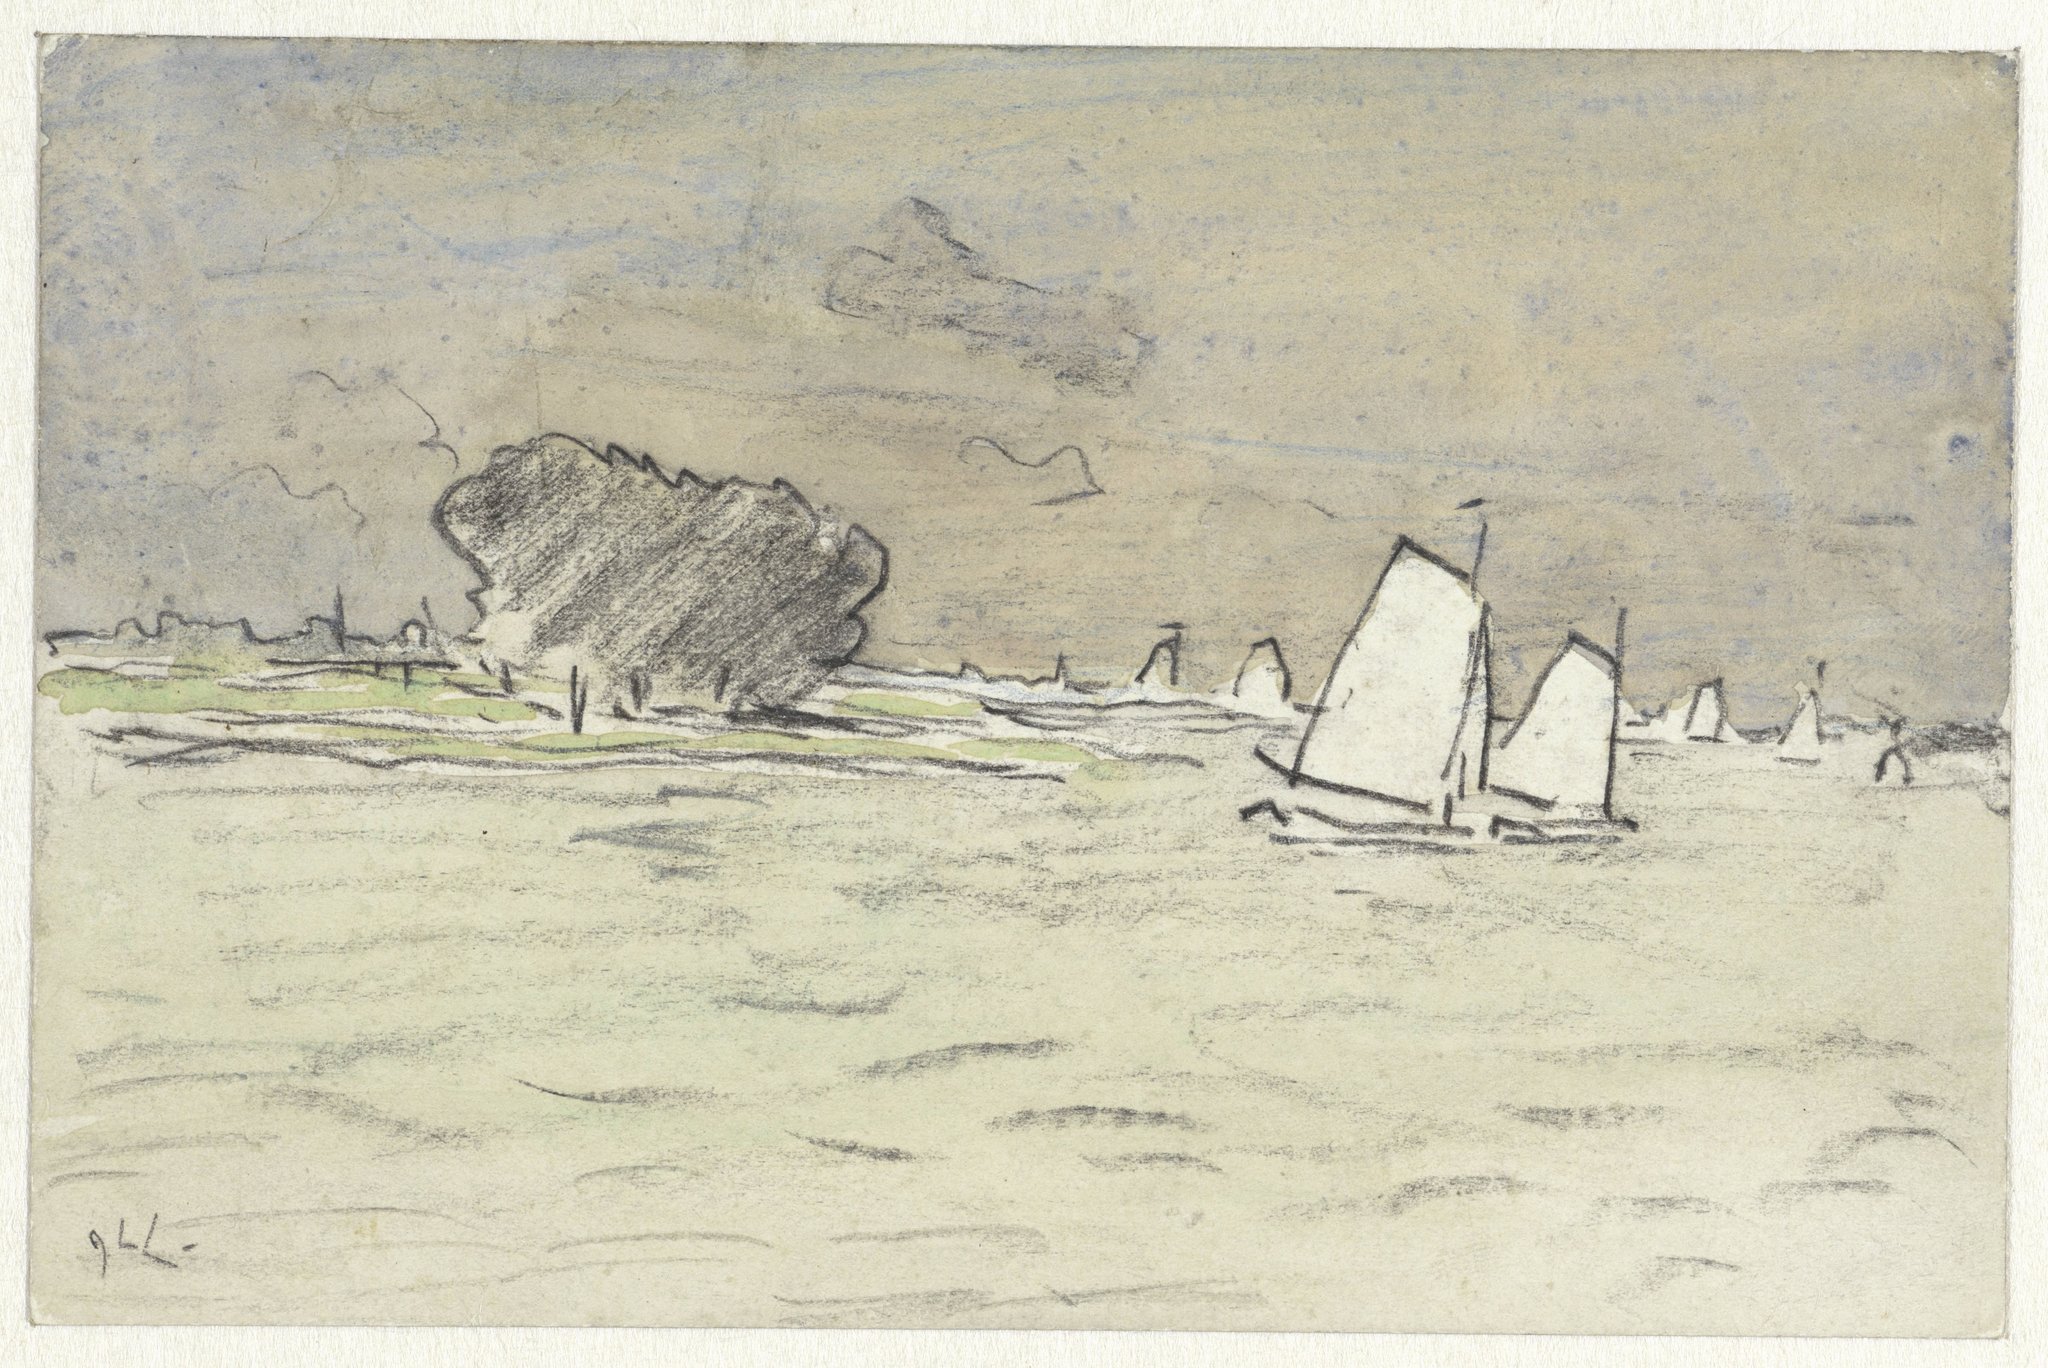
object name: drawing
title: Zeilschepen bij rivieroever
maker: adolf le comte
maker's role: draughtsman, painter, print maker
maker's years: 1850-1921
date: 1860-1921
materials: chalk, paper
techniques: brush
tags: sailing-ship, sailing-boat, river